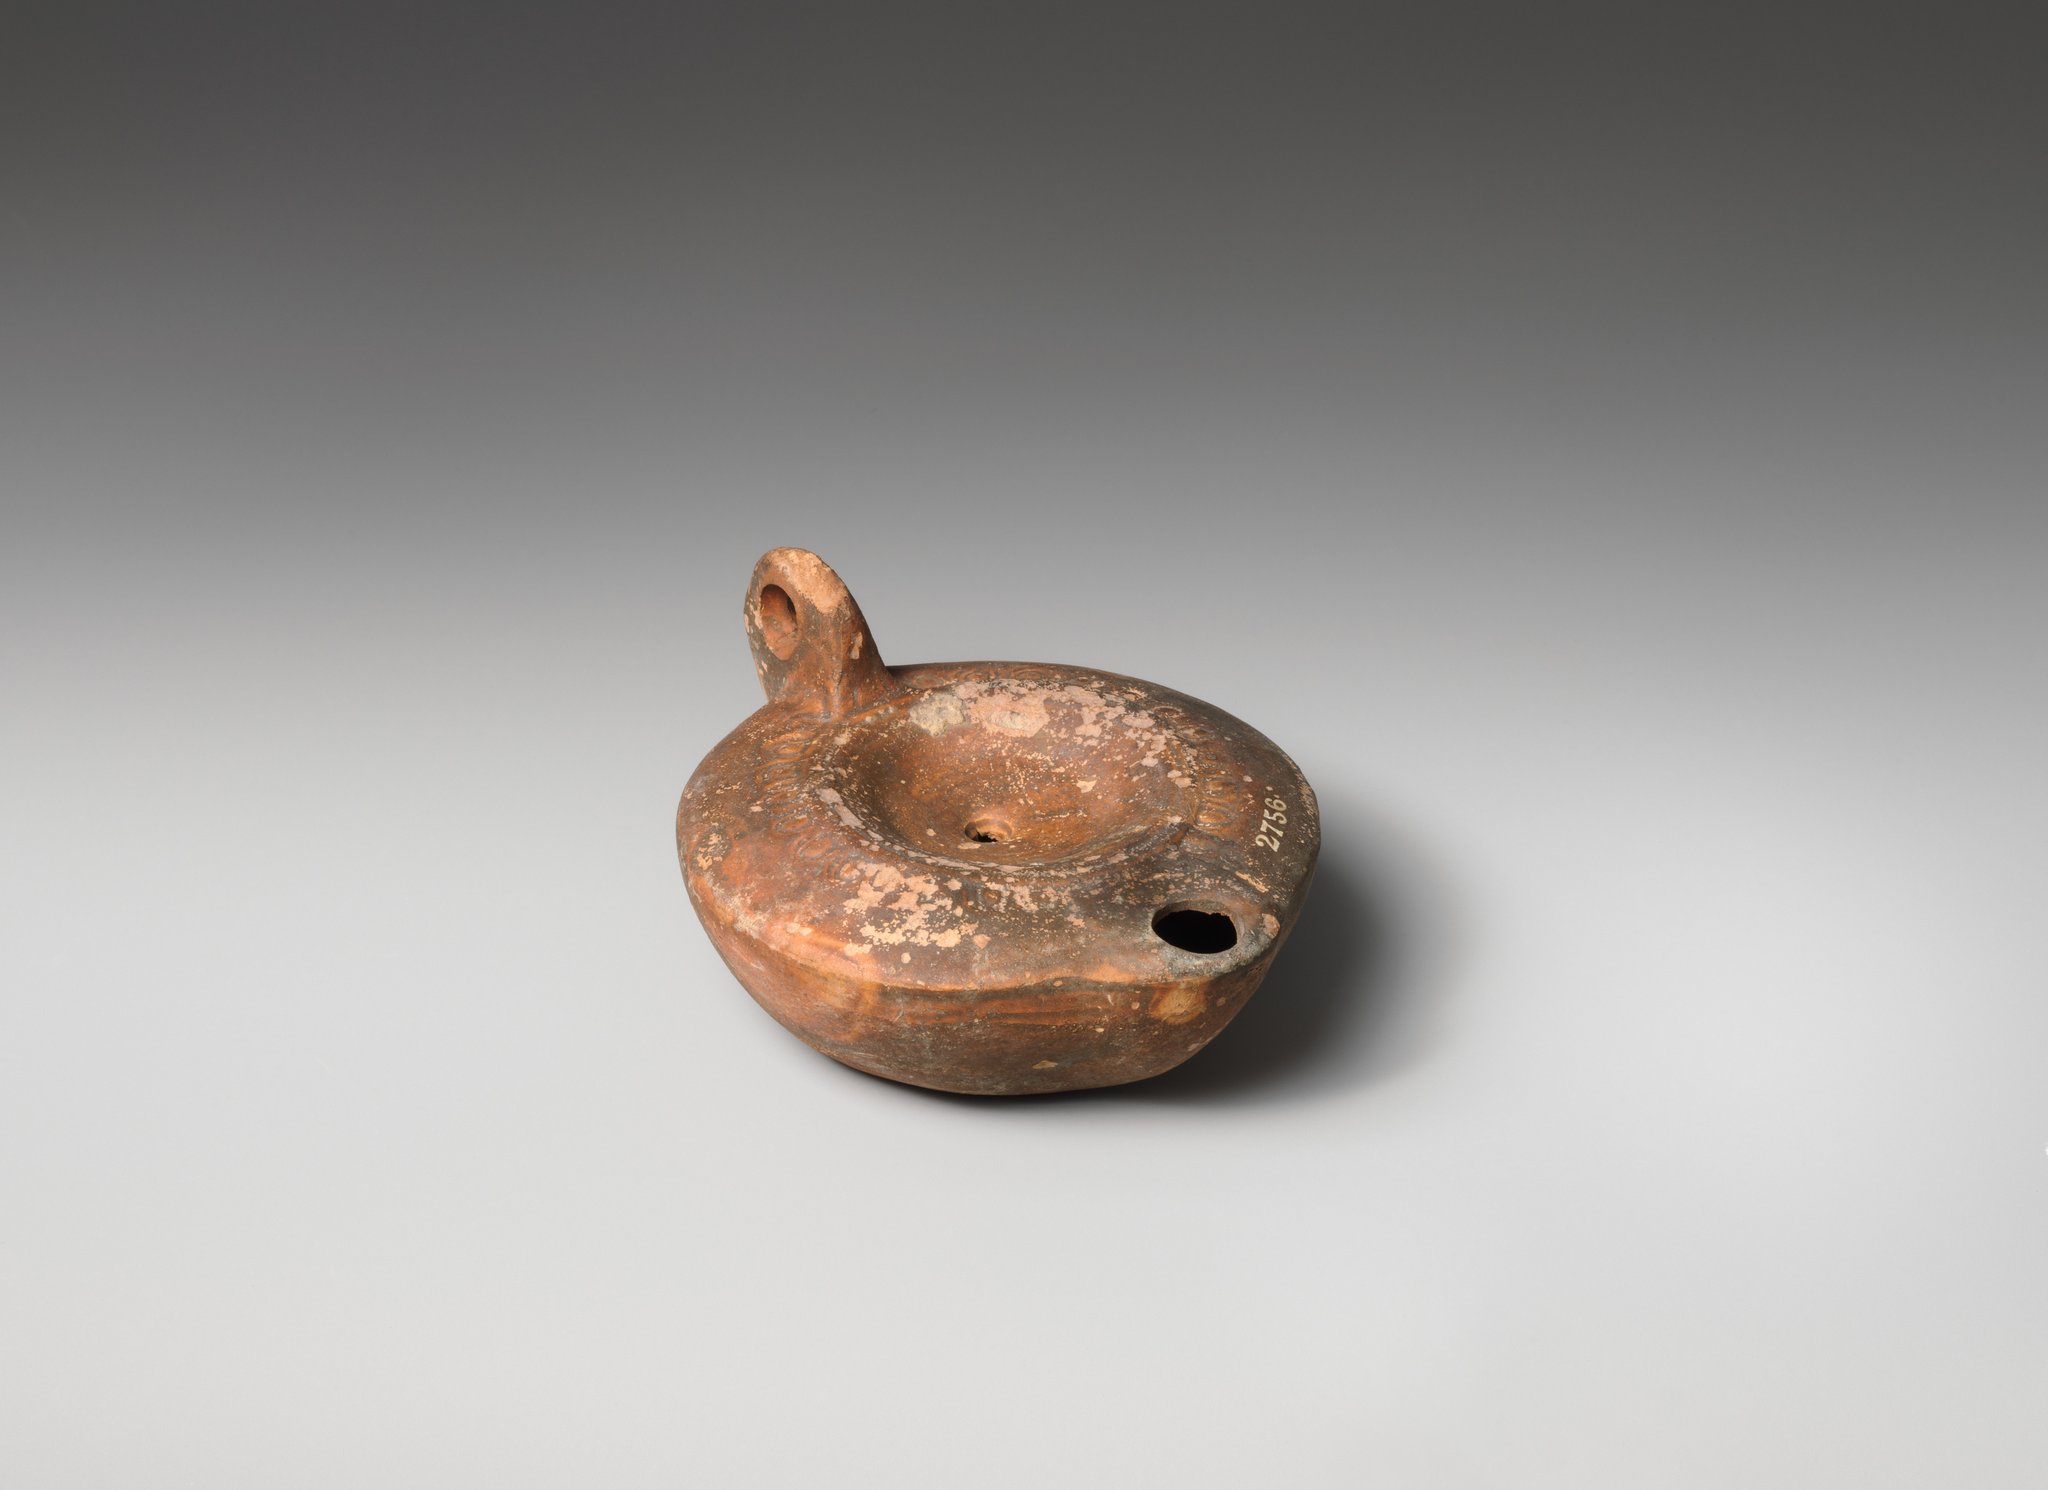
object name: lamp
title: Terracotta oil lamp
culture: roman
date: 101-200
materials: terracotta